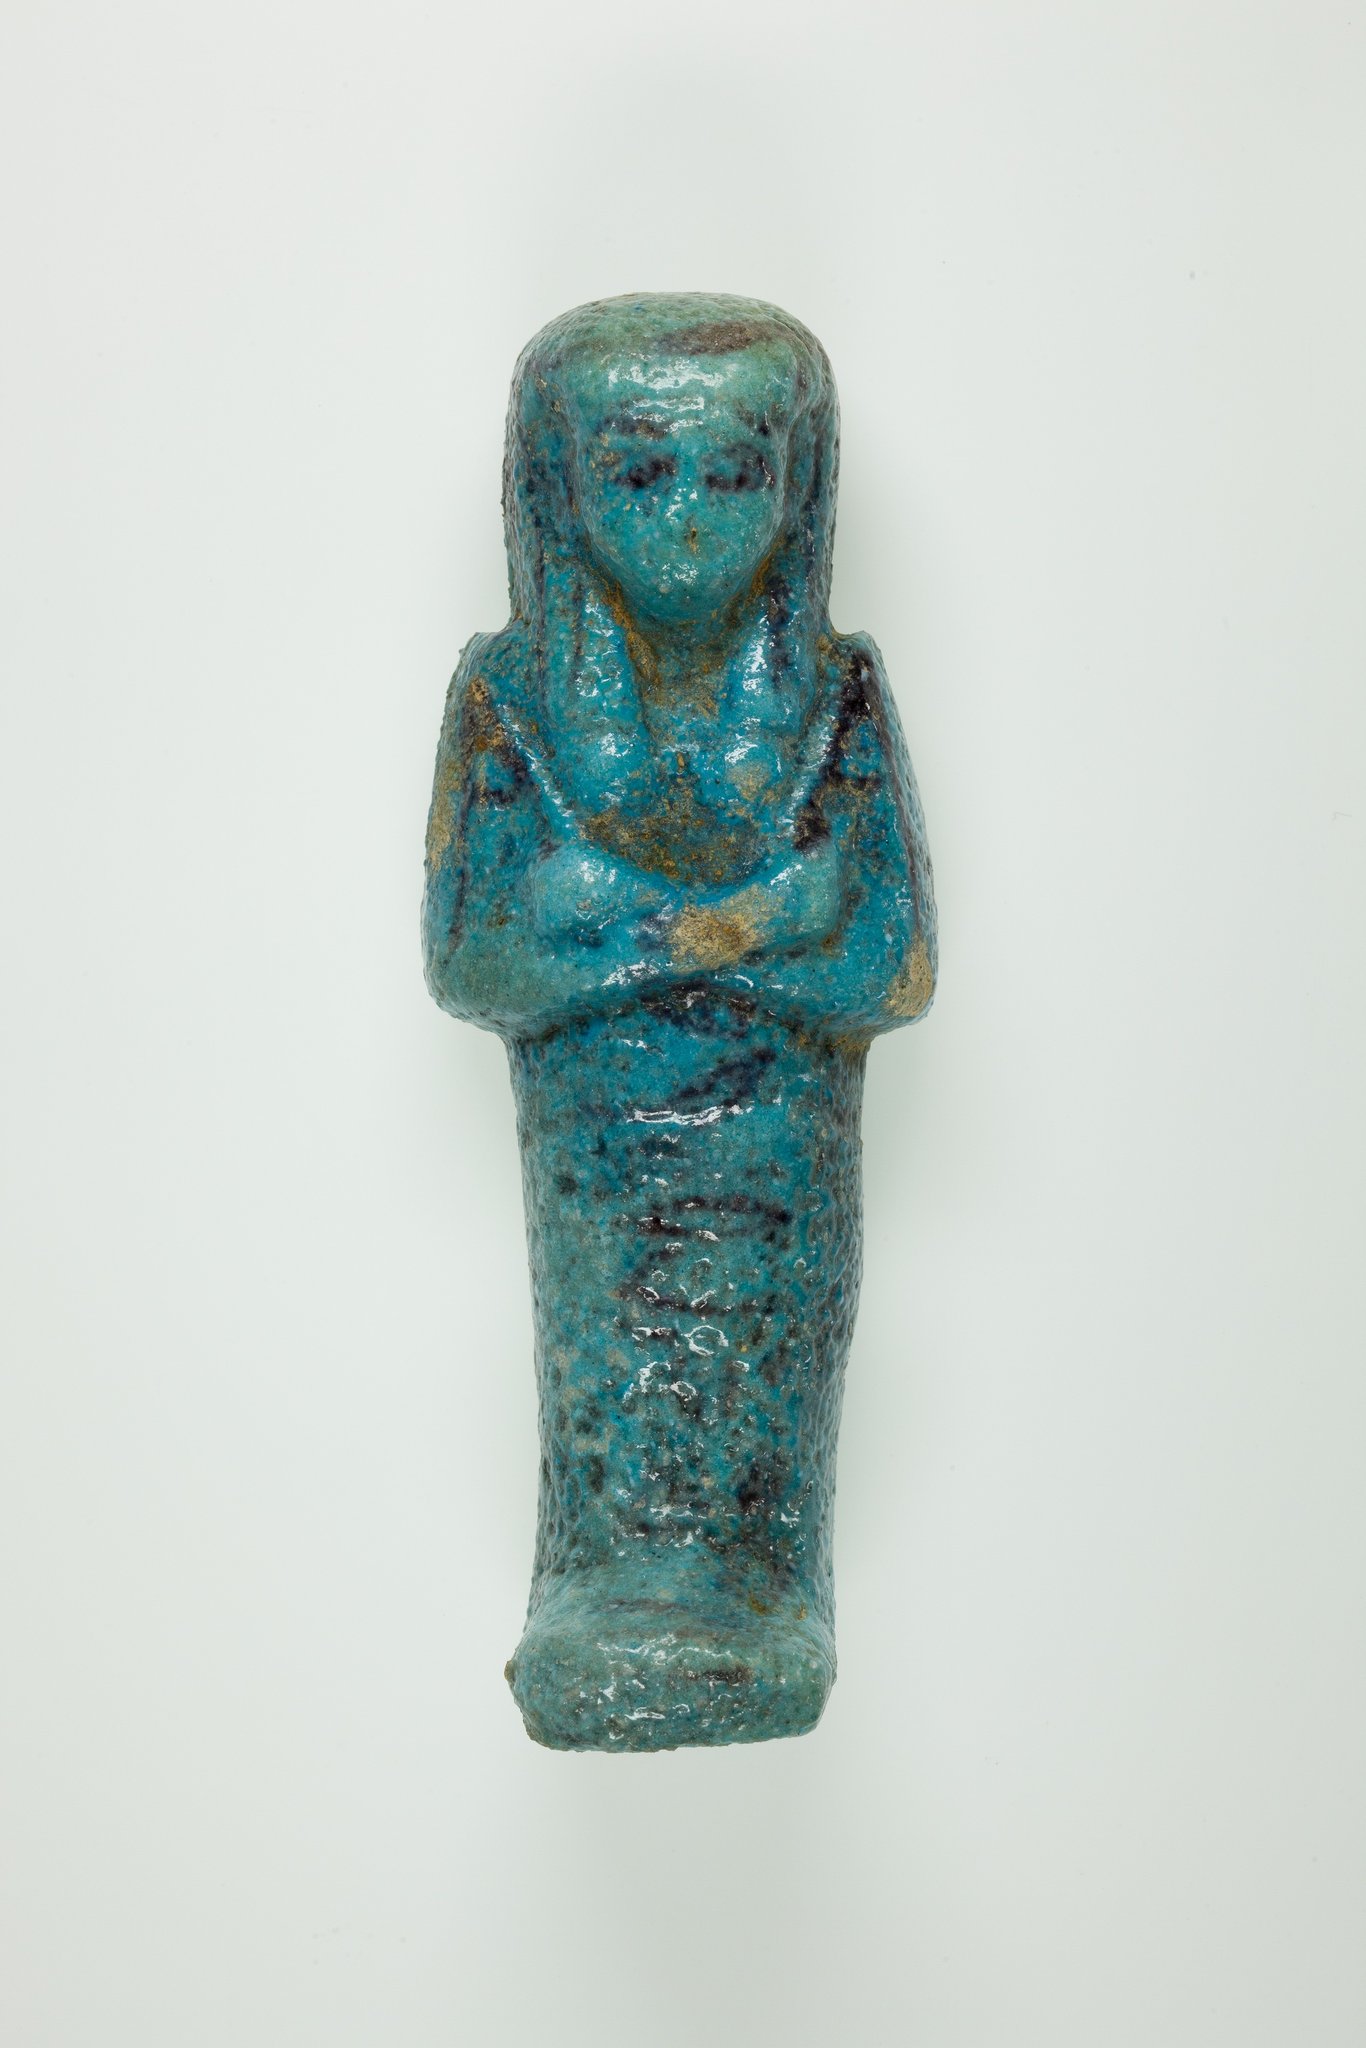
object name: worker shabti, henettawy c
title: Worker Shabti of Henettawy (C), Daughter of Isetemkheb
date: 990-970 BCE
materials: faience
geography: egypt